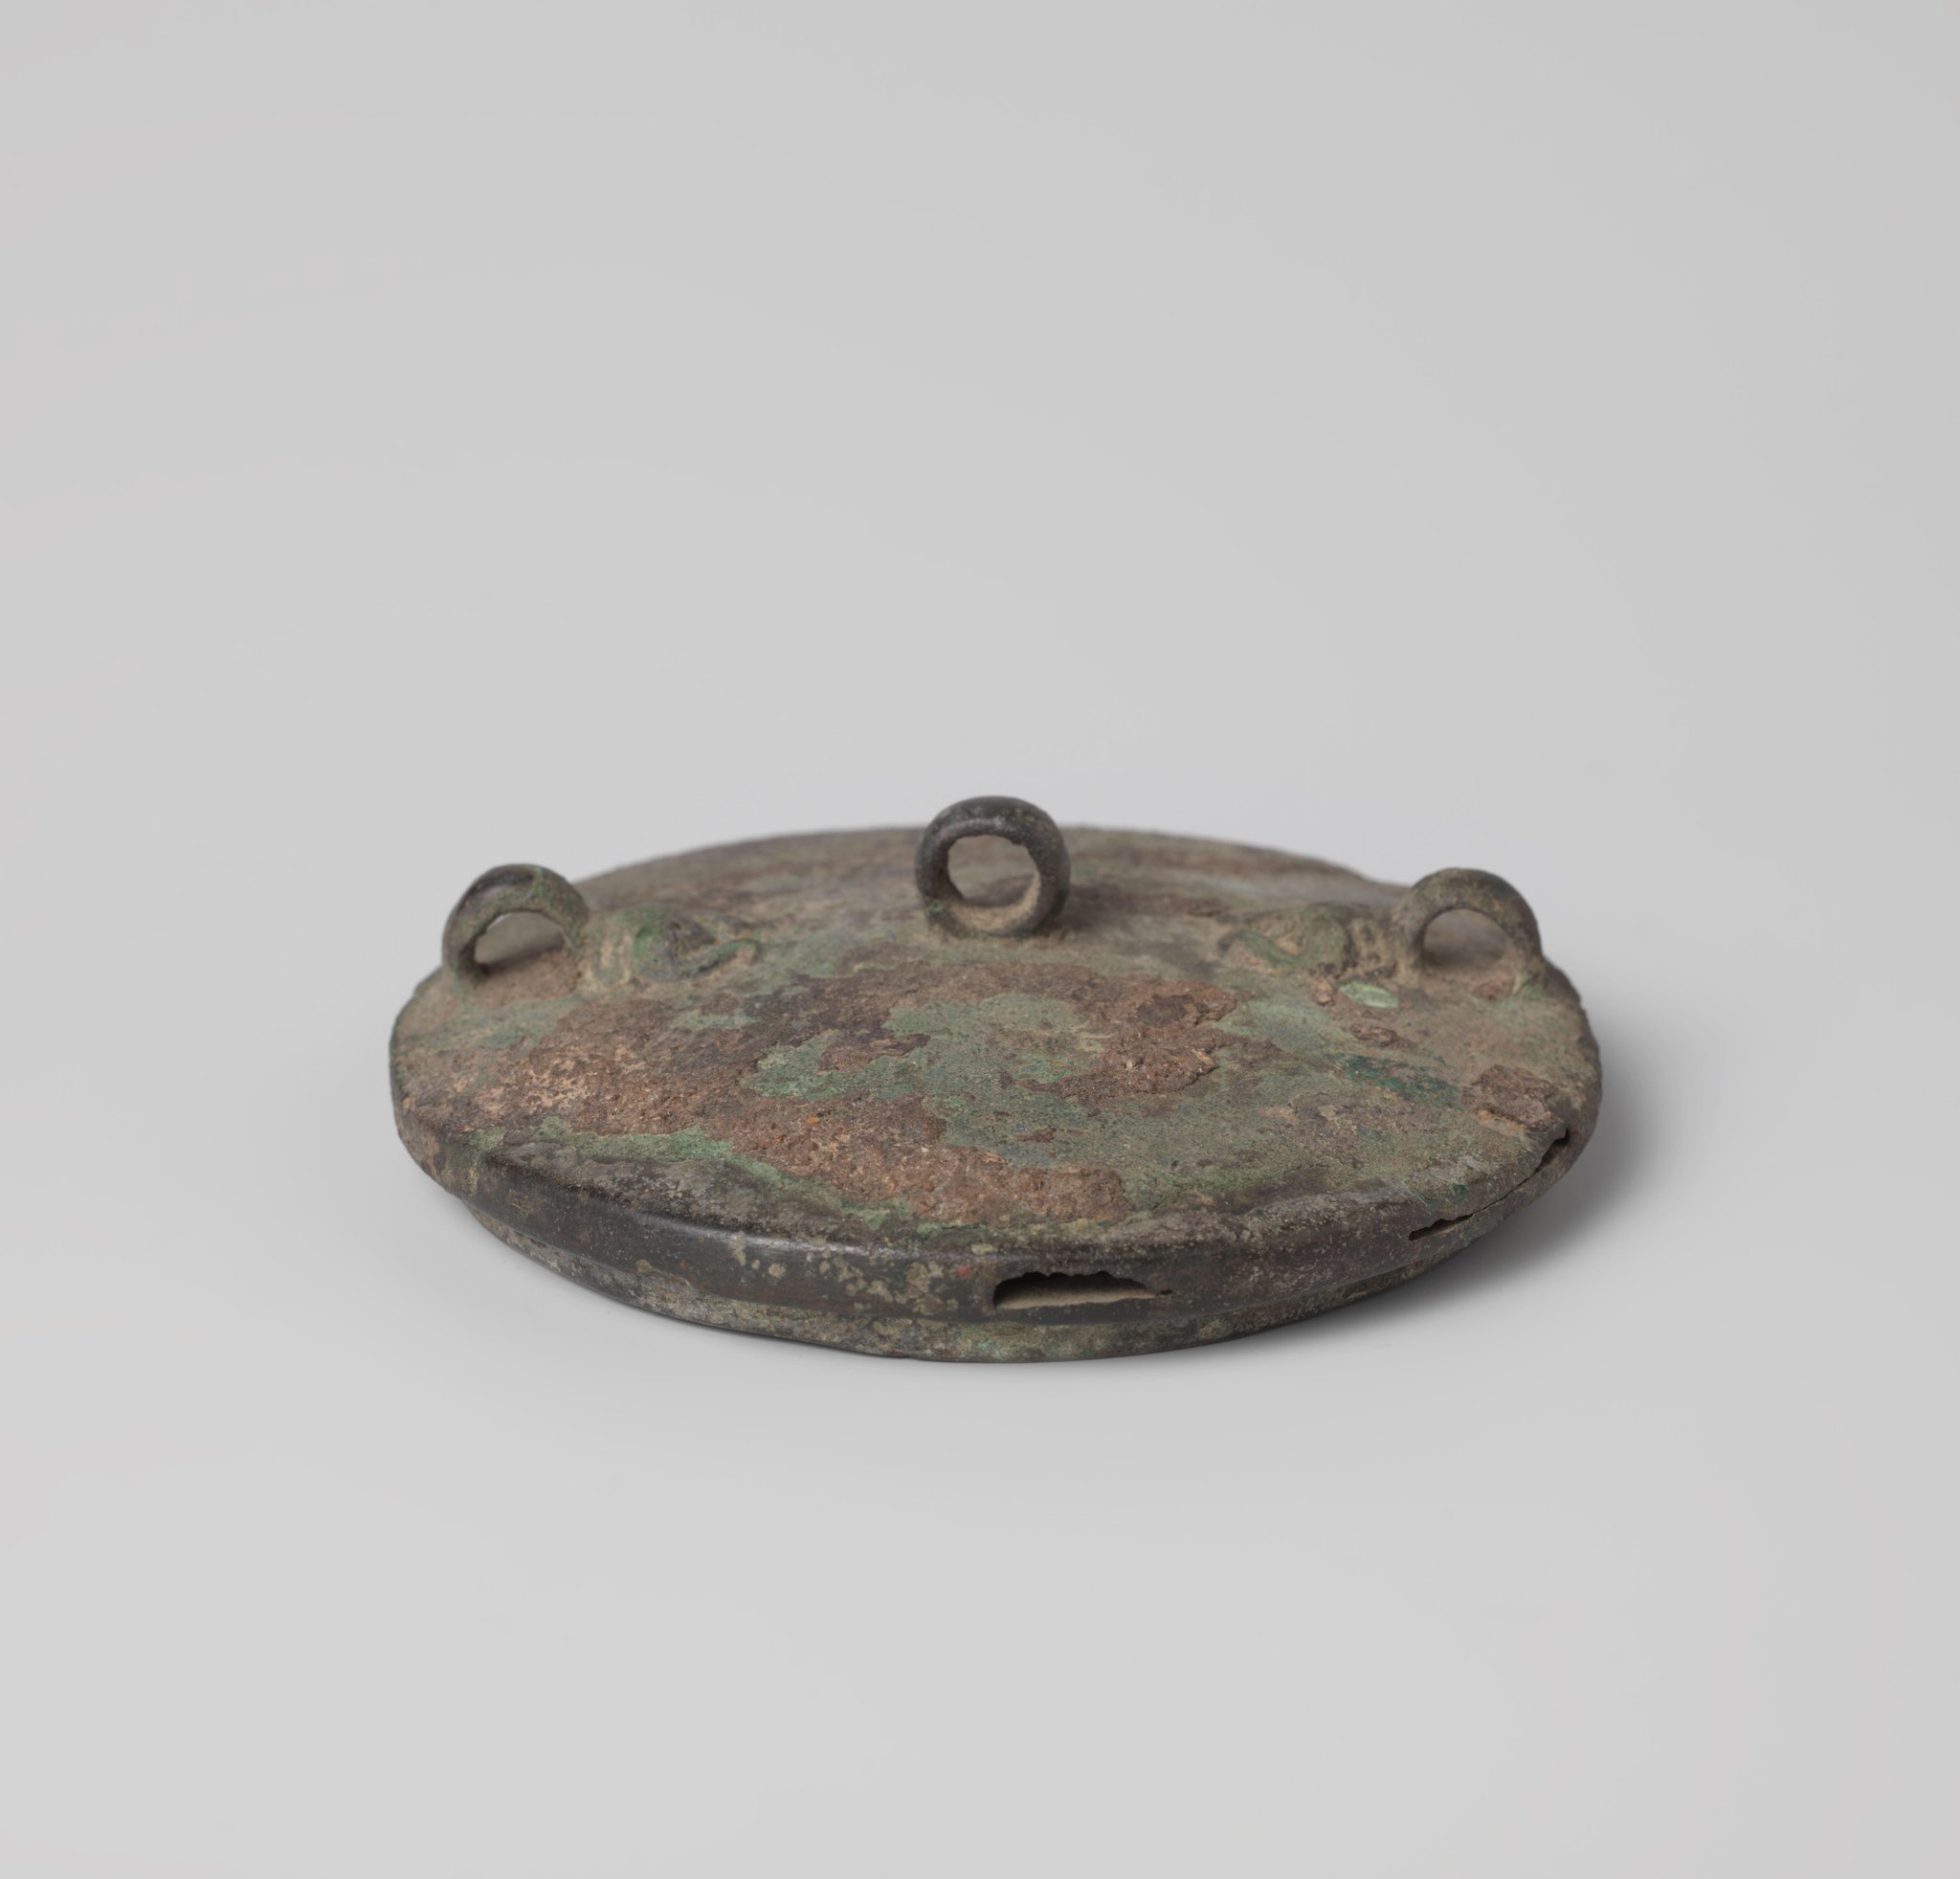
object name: hu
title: Deksel van ritueel vat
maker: Anonymous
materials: bronze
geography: china